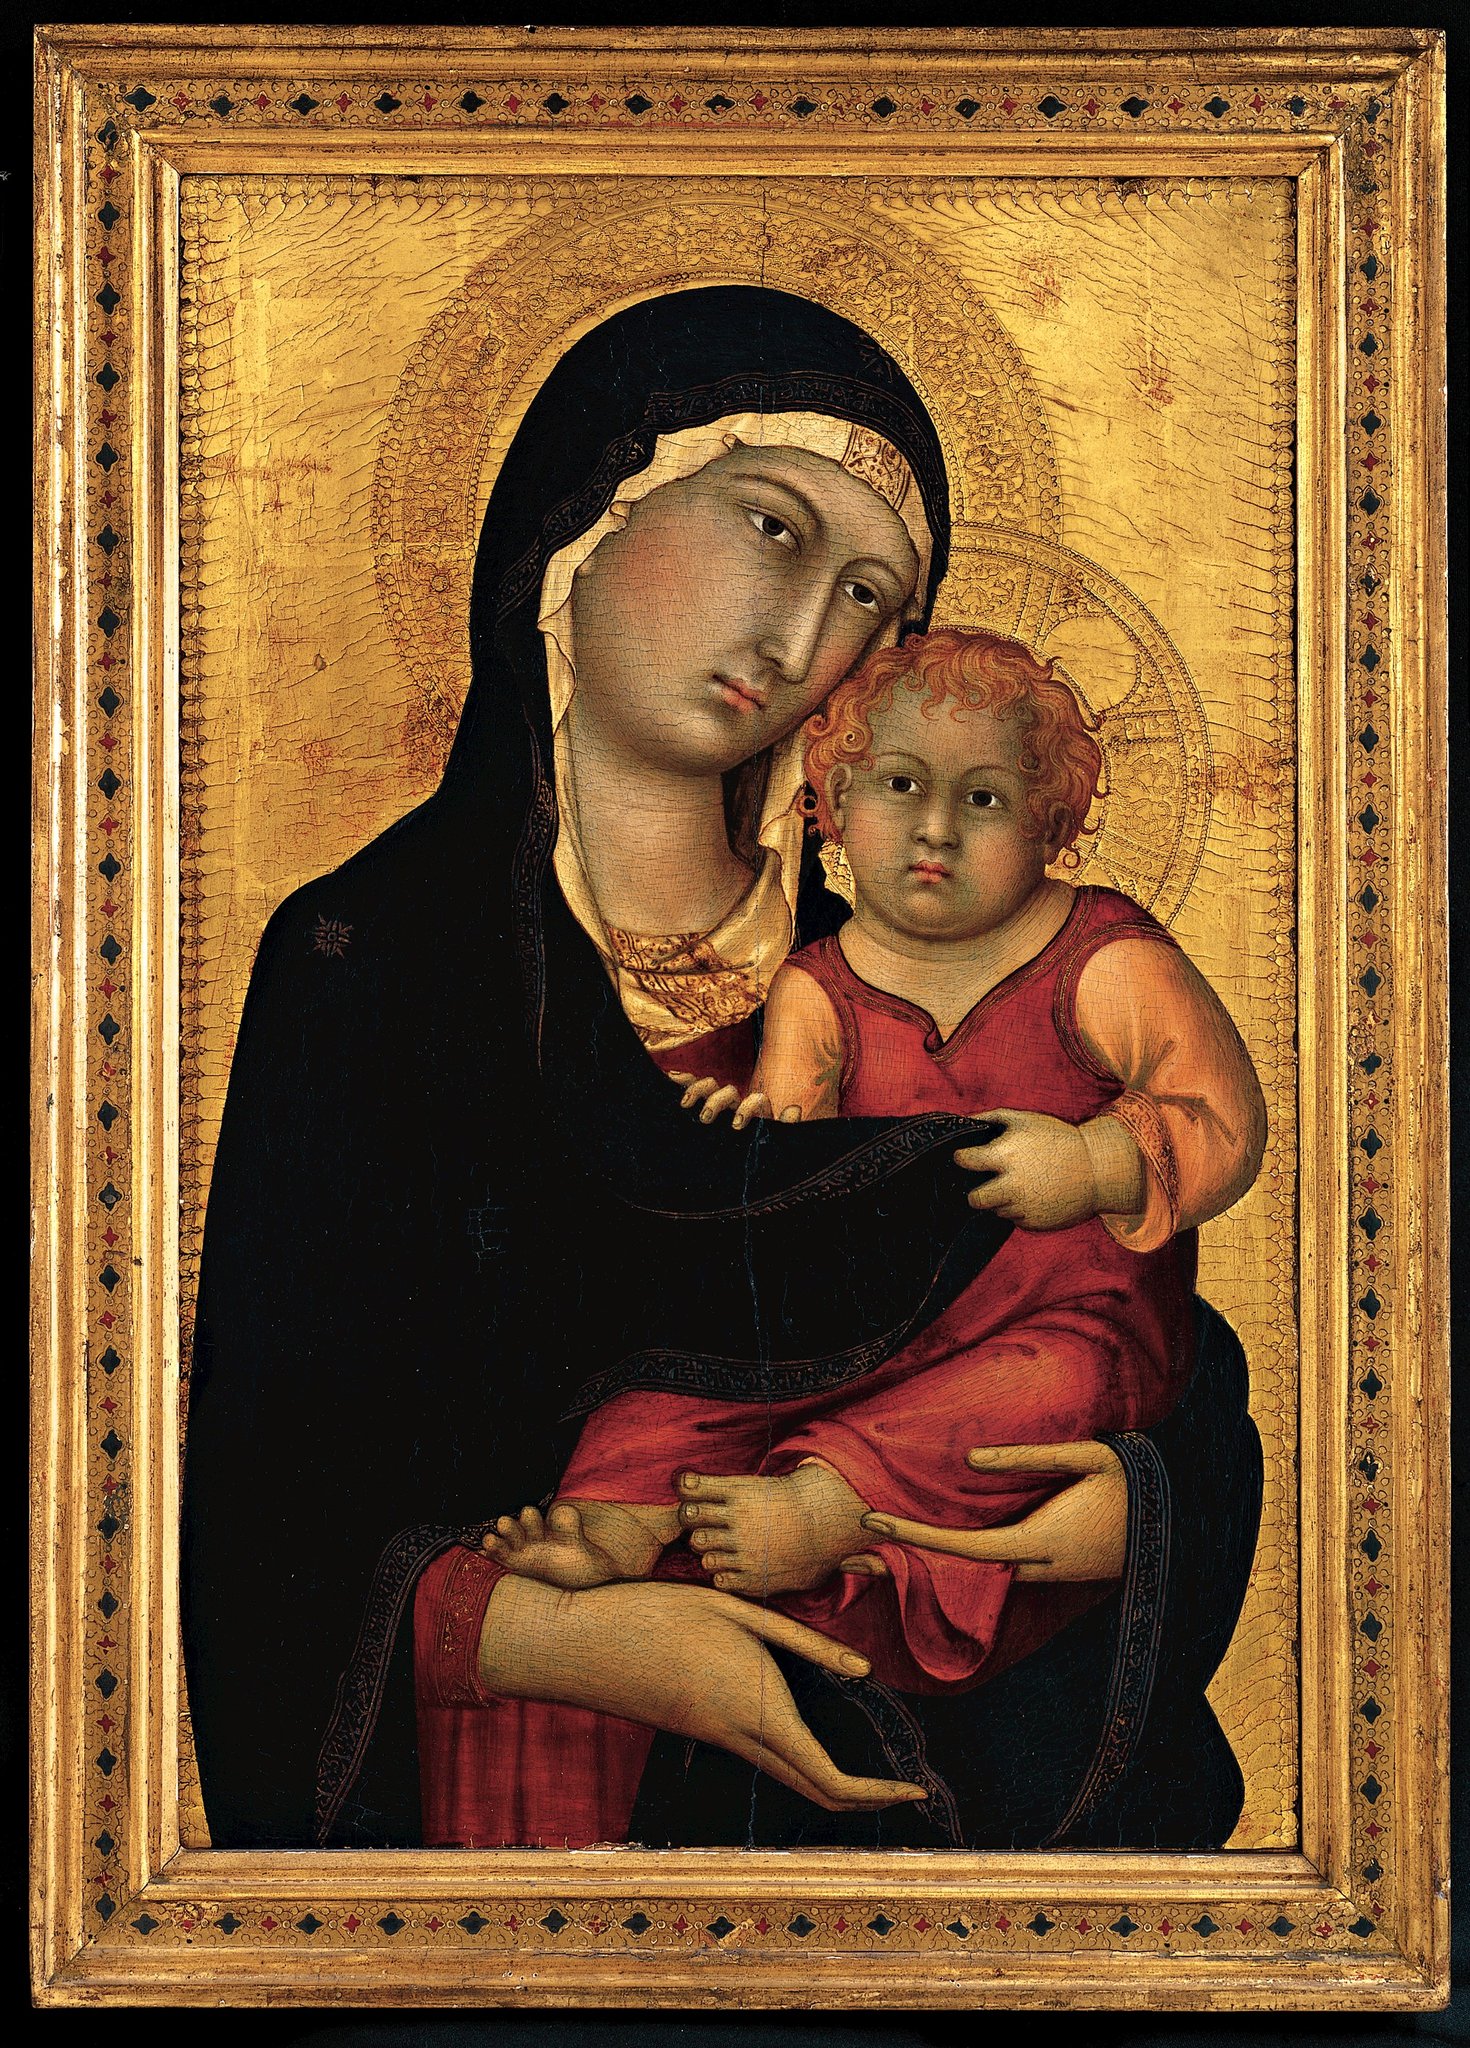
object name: frame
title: Cassetta frame on a polyptych panel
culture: italian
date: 1325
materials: gilt, wood